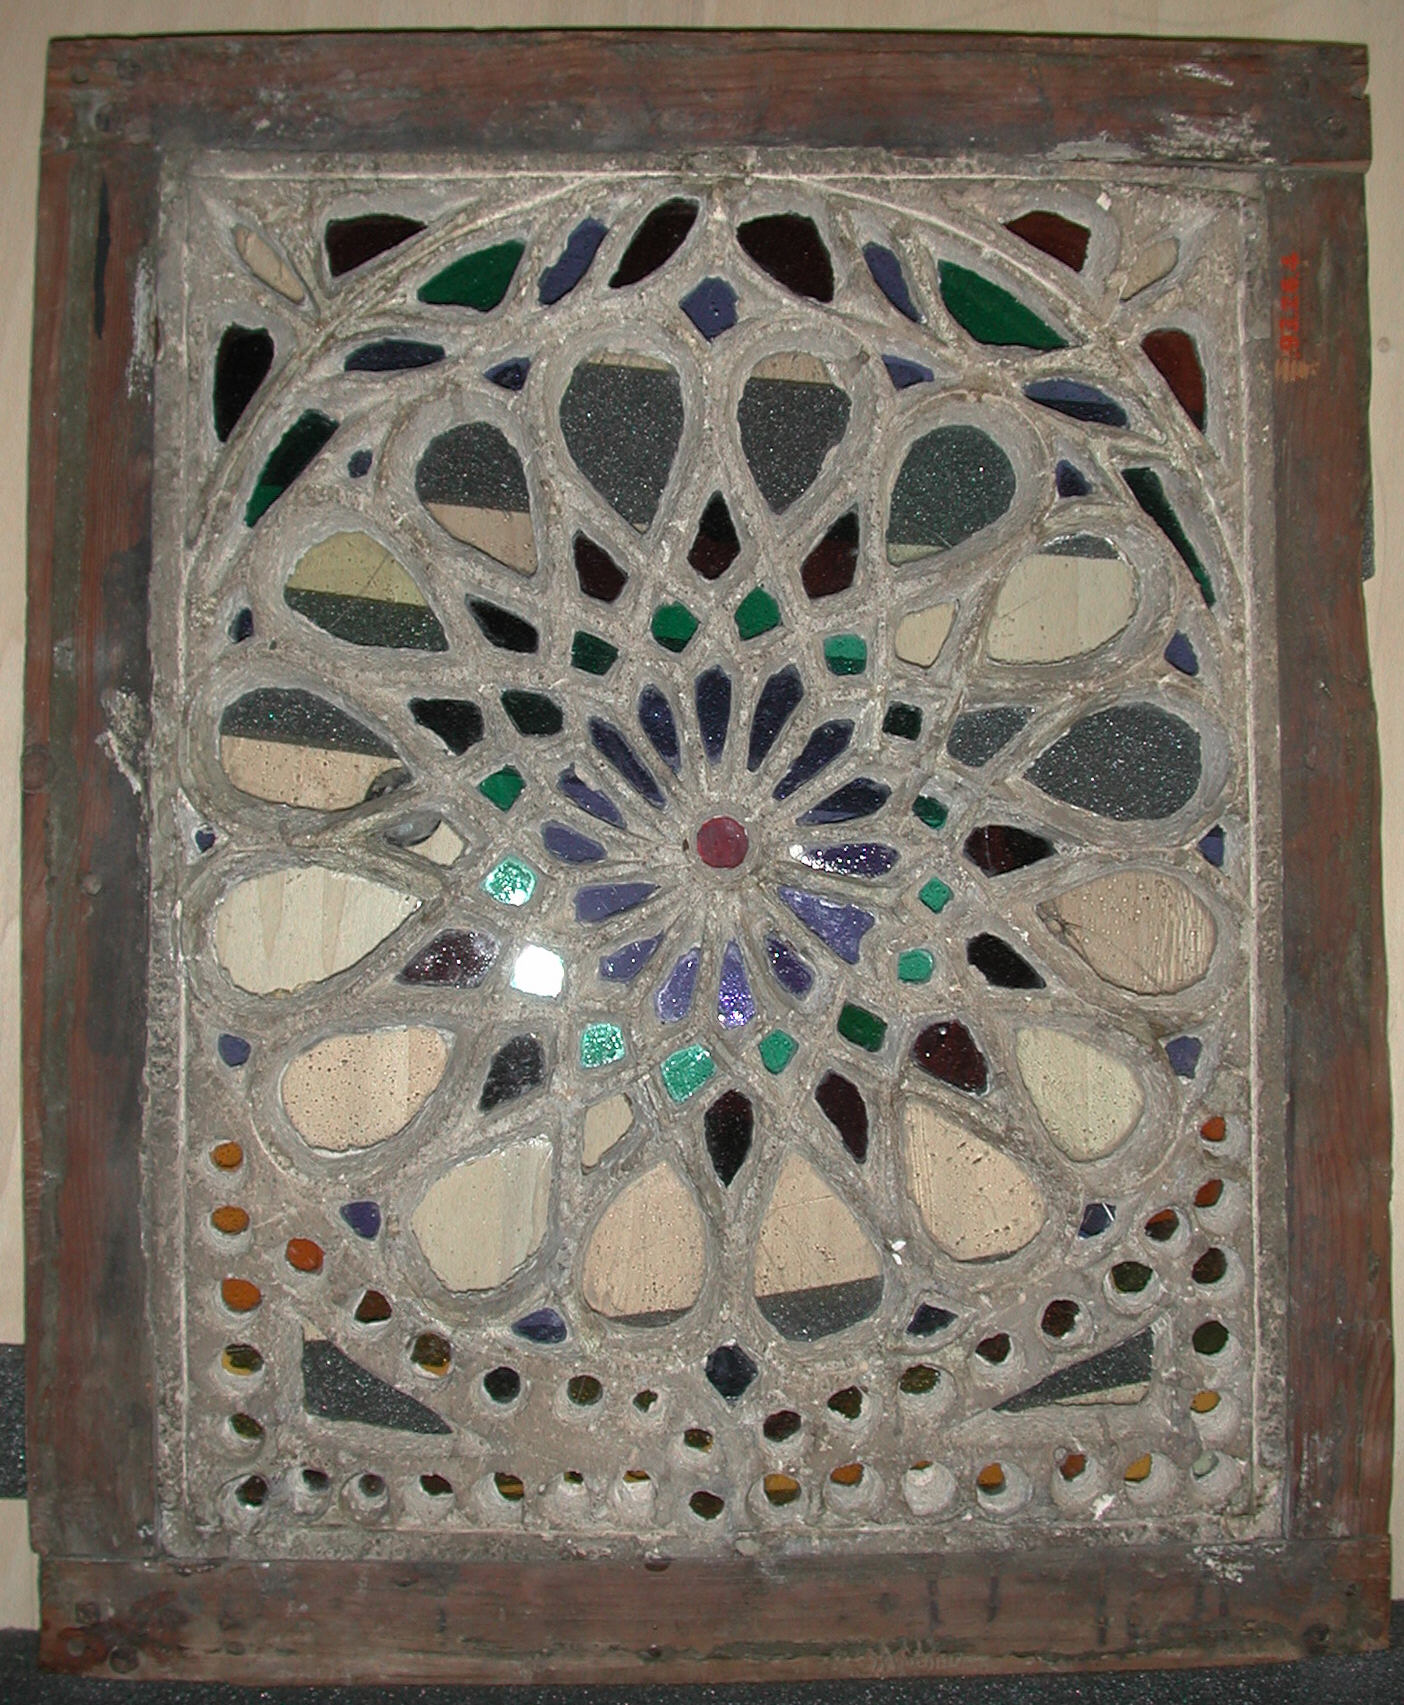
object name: window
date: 1601-1700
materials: gypsum, glass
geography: egypt or syria